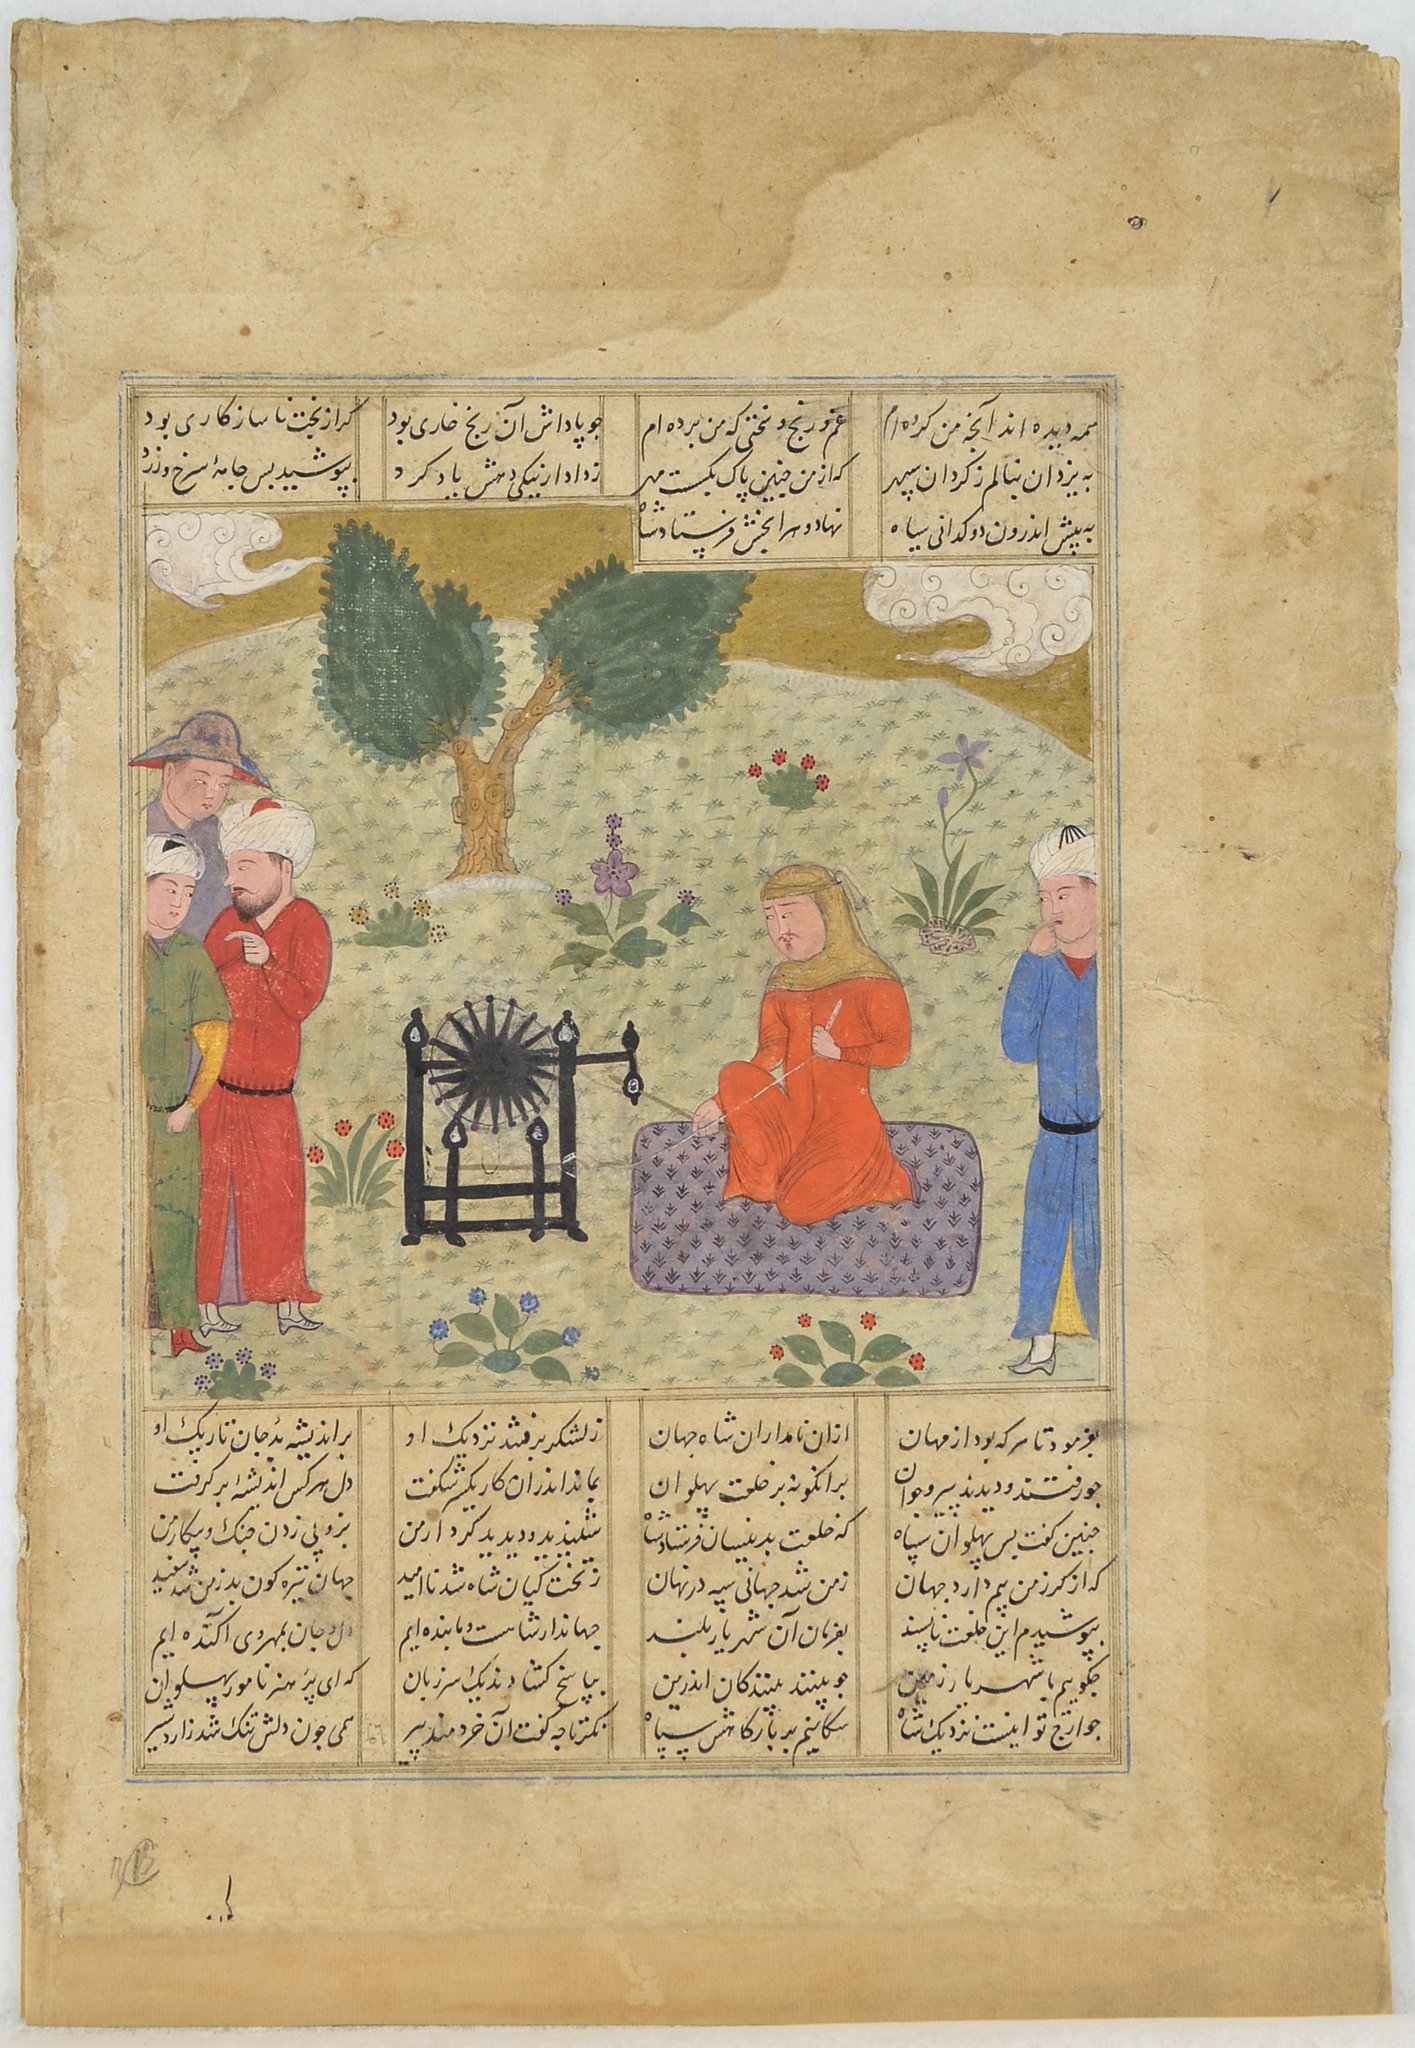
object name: folio from an illustrated manuscript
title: "Bahram-e Chubineh Wears Women's Clothing and Spins Yarn", folio from a Shahnama (Book of Kings) of Firdausi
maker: abu'l qasim firdausi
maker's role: author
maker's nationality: iranian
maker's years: 935-1020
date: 1480-1490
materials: gold, ink, paper, watercolor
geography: iran